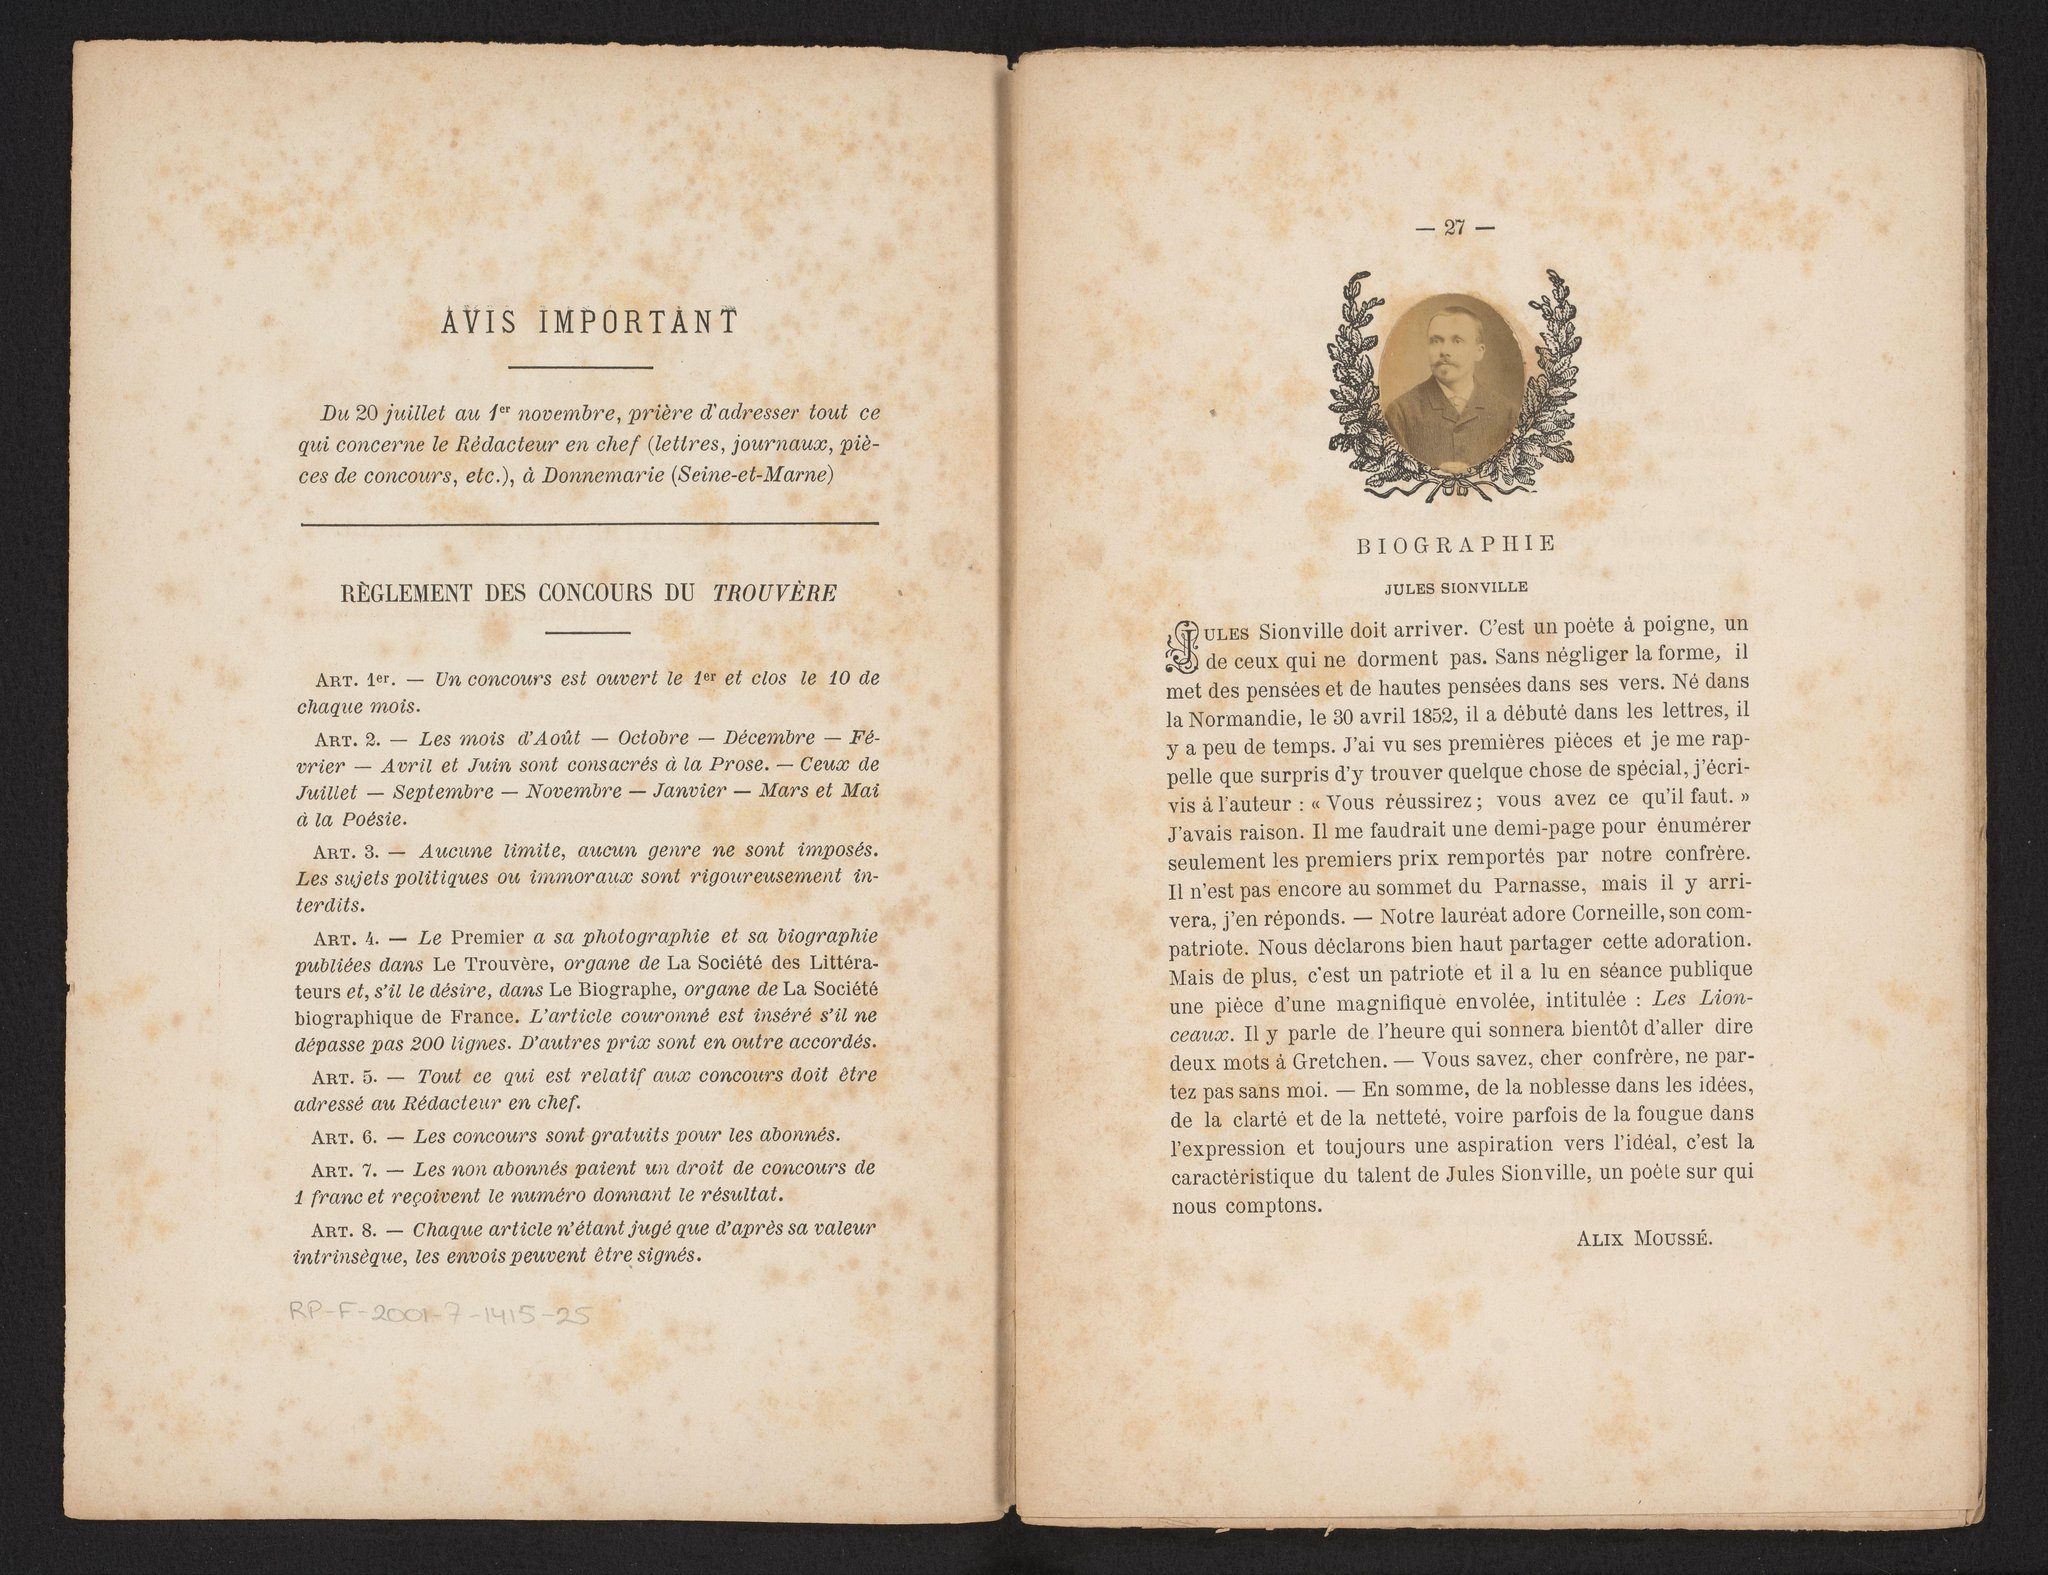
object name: page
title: Portret van Jules Sionville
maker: Anonymous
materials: photographic support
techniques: albumen print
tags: historical persons